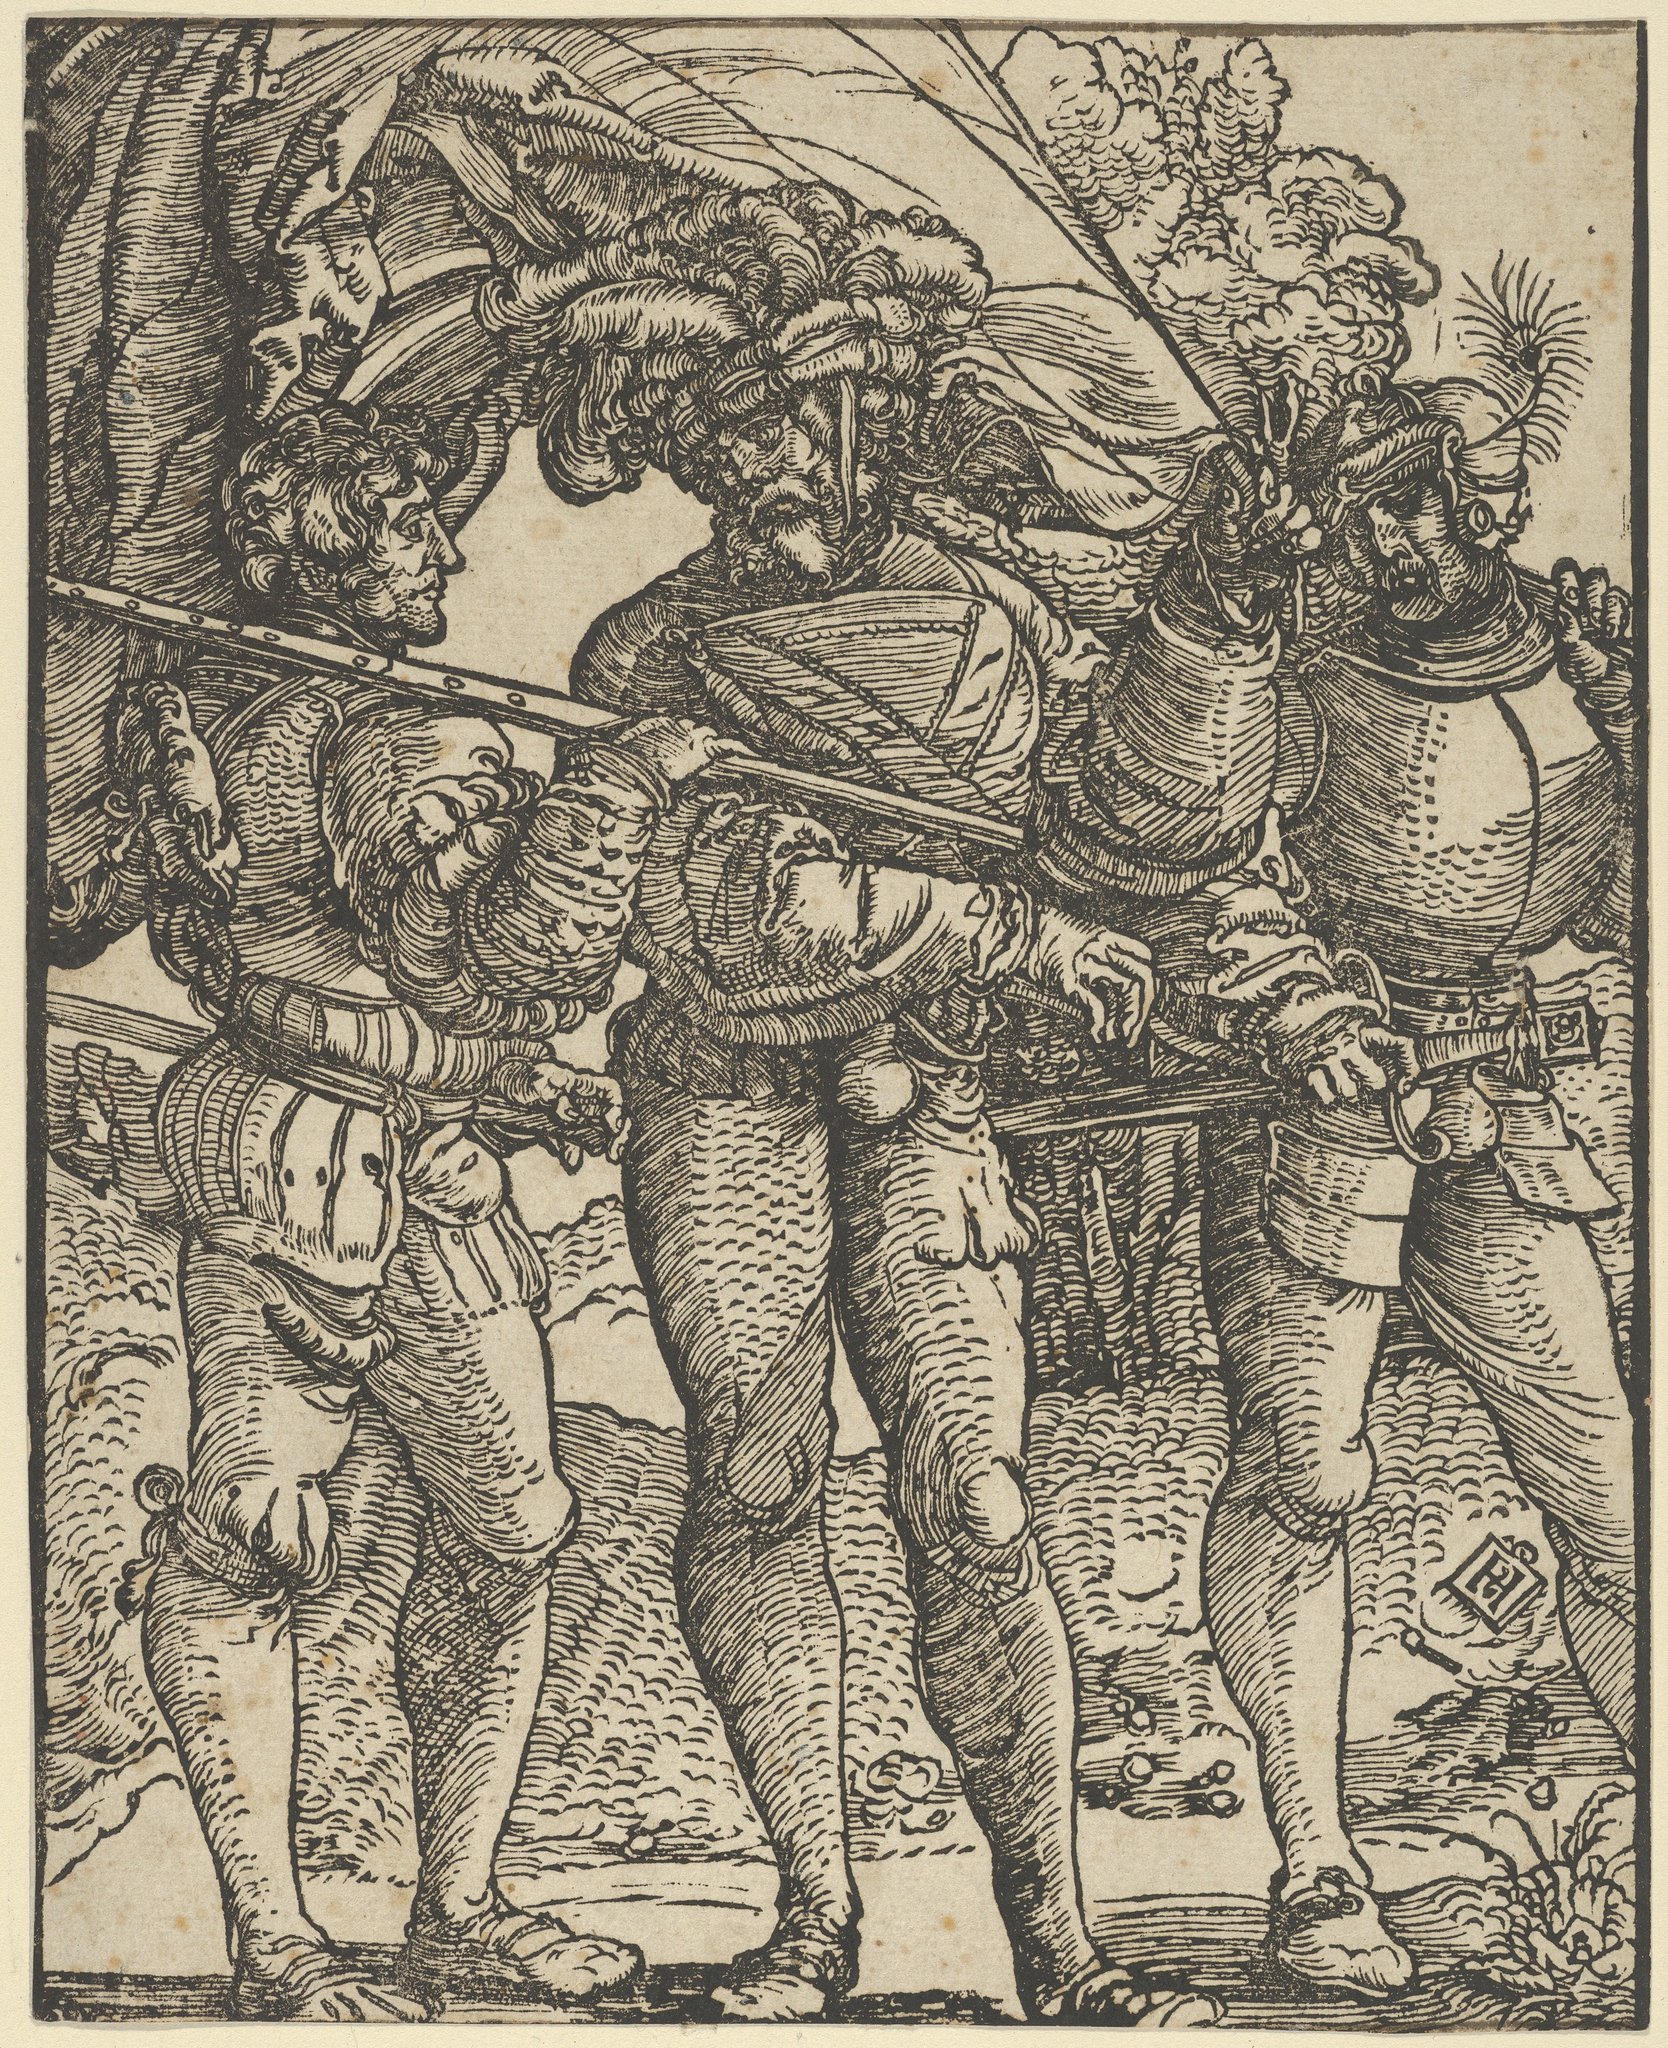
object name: print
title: A Standard-Bearer Flanked by a Lansquenet at each side (copy)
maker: hans schäufelein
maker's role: artist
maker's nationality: german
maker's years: 1480-1540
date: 1500-1540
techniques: woodcut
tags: soldiers,weapons,men,flags